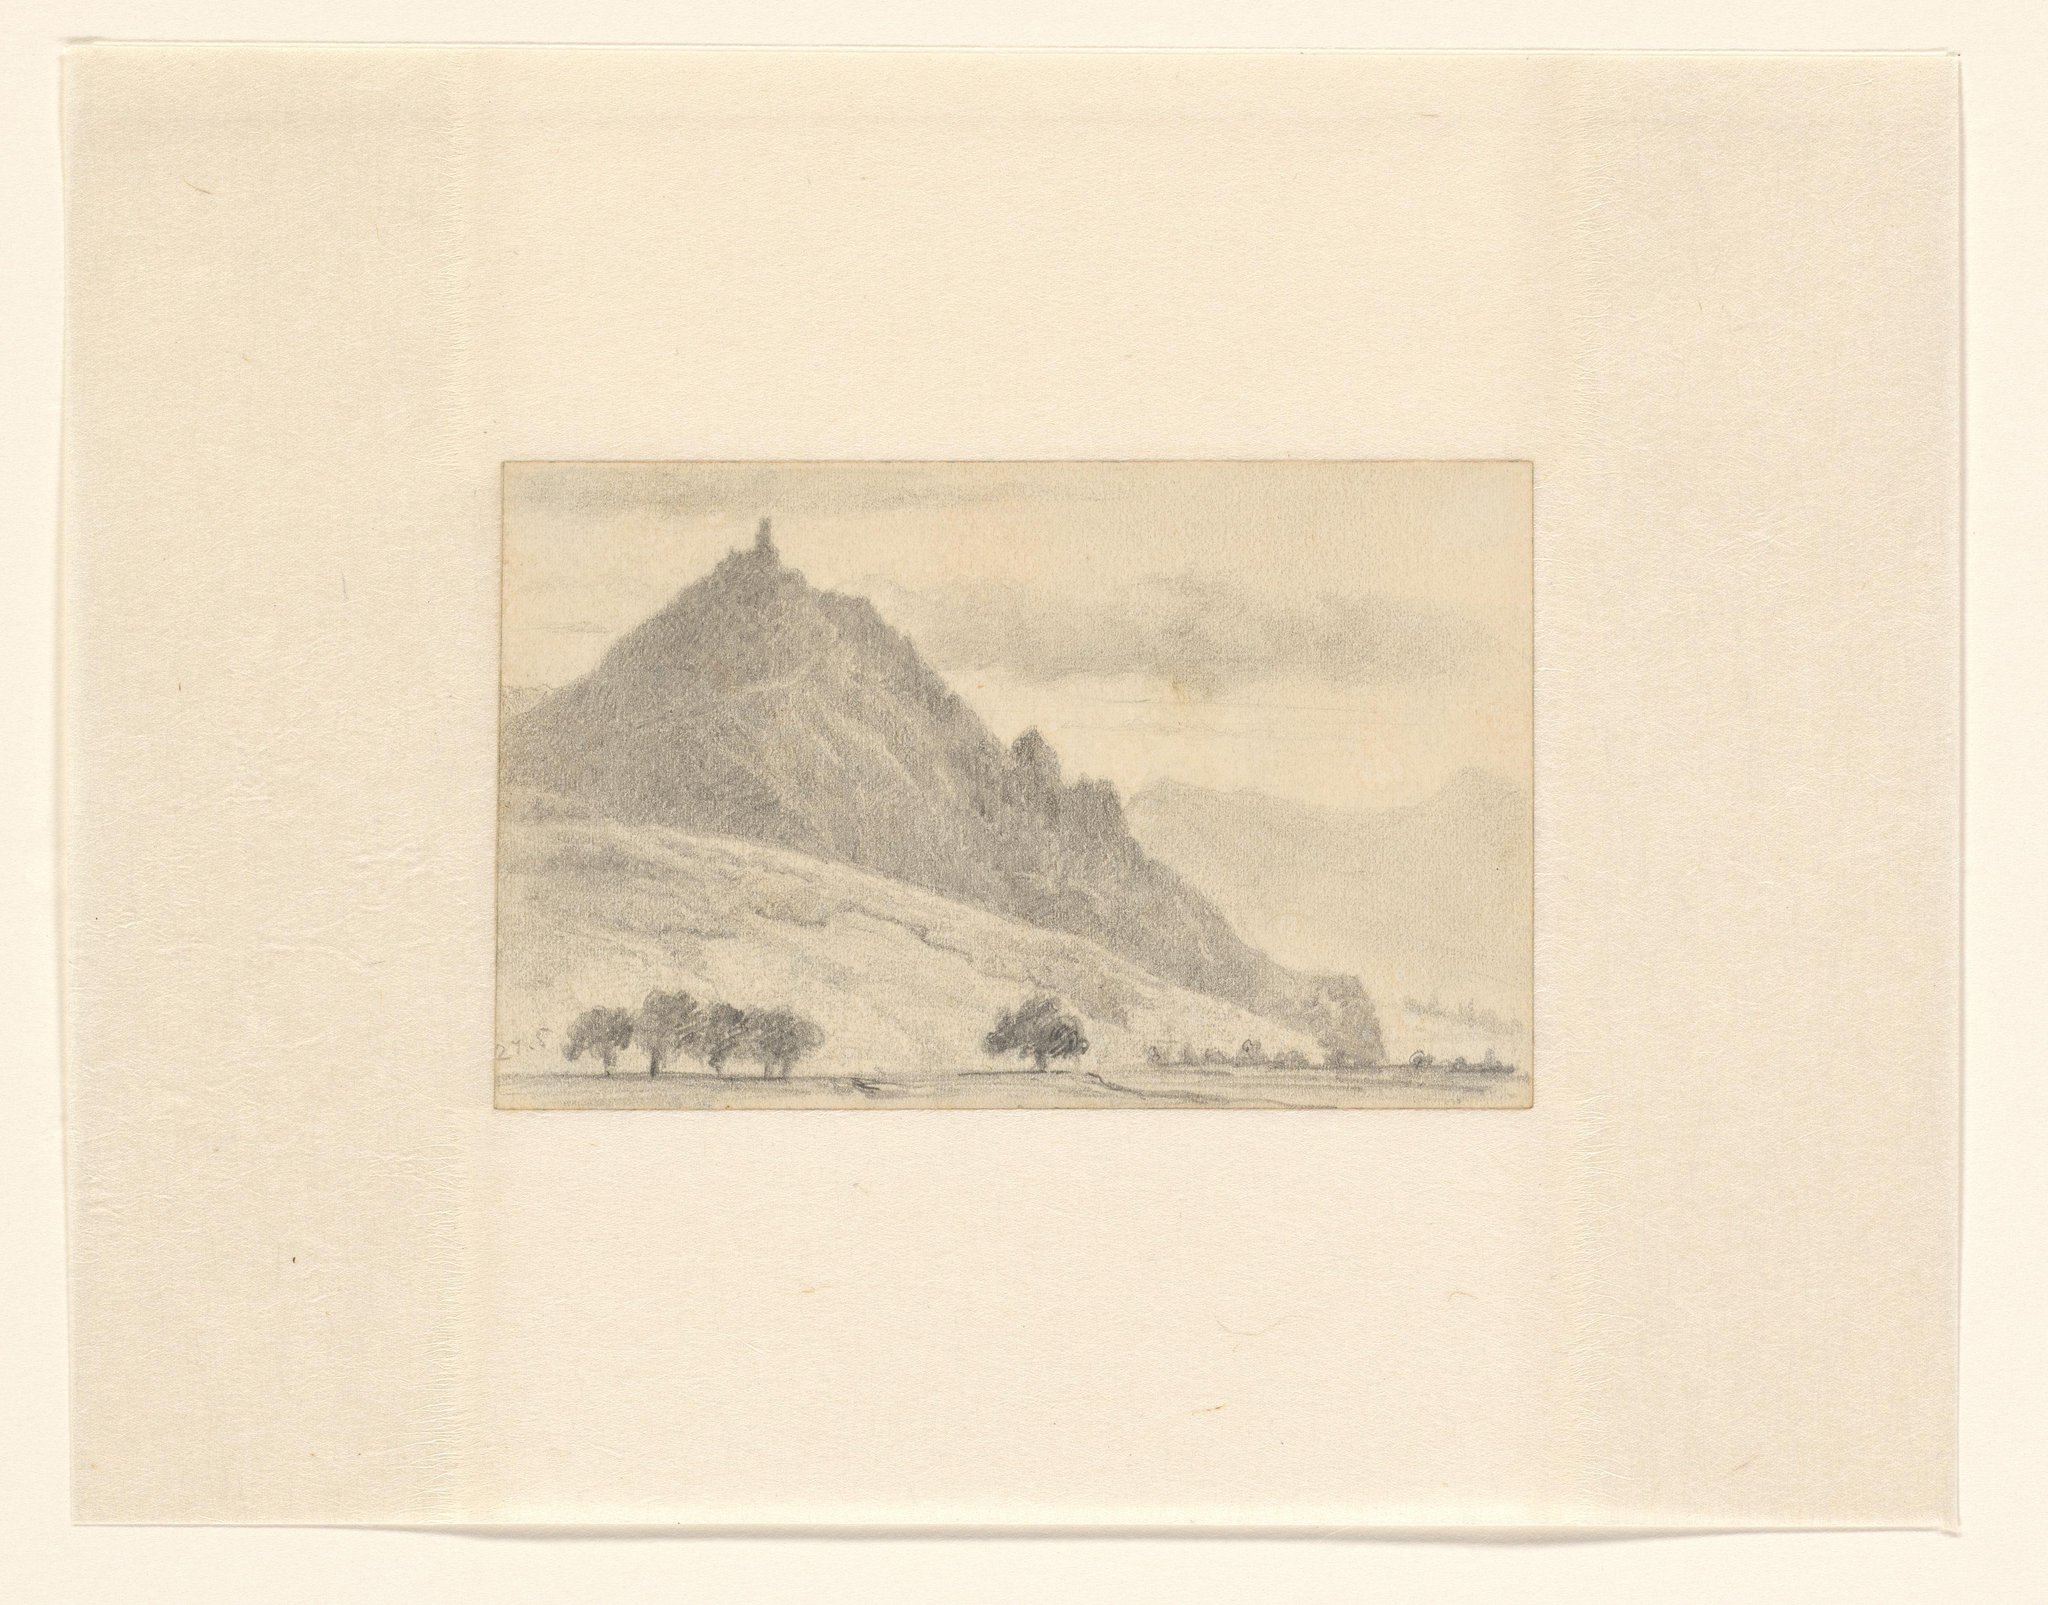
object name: drawing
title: Berglandschap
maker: louis charles hora siccama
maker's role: draughtsman, print maker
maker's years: 1807-1880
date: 1864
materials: paper, pencil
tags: mountains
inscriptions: inscription: ‘2 Aug 1864/ B[...]/ Mathilde’